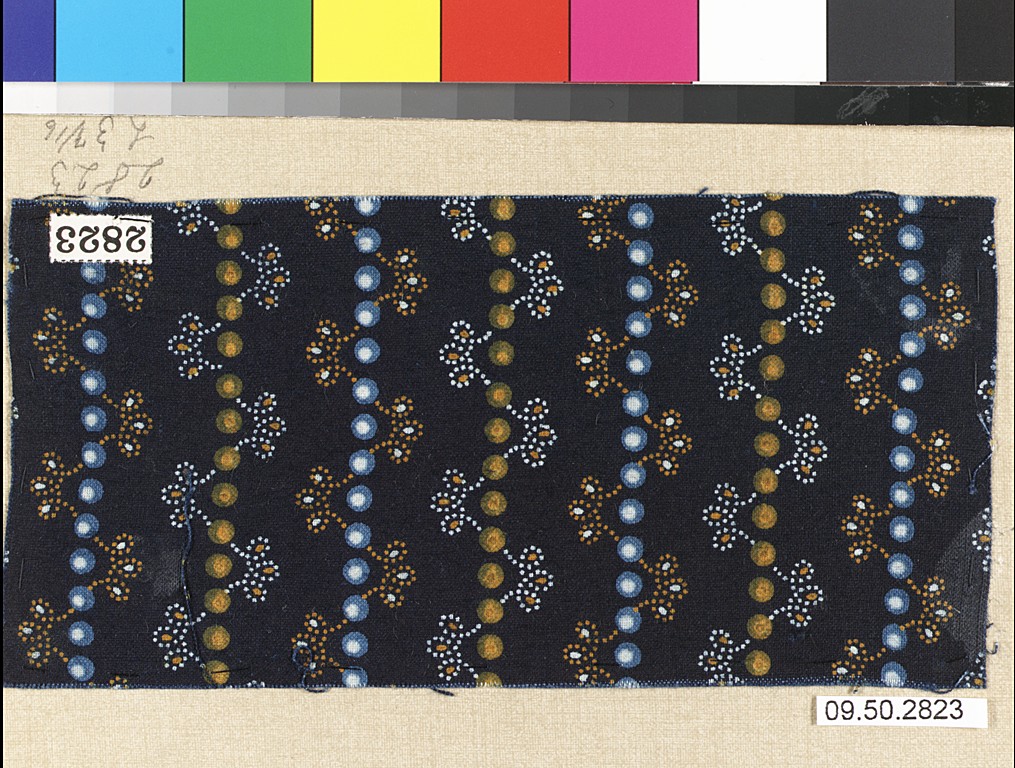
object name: piece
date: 1801-1900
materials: cotton